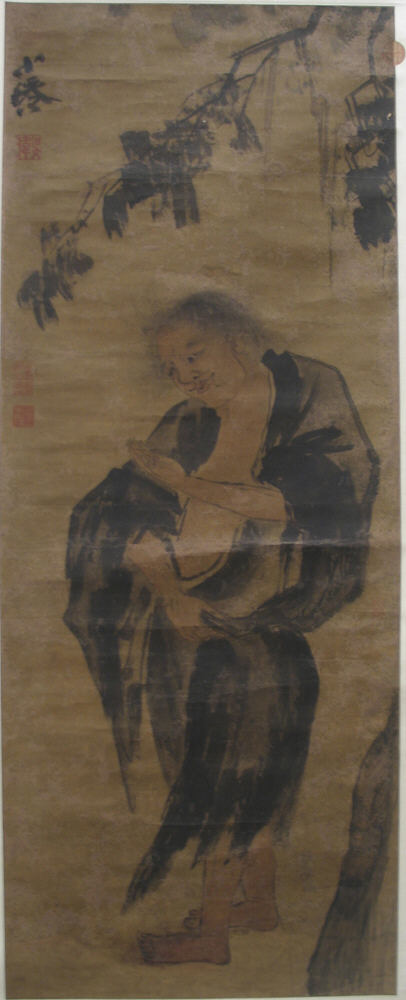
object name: hanging scroll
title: The Immortal, Zhong li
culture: chinese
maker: unidentified artist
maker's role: artist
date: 1368-1911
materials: ink, paper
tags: men